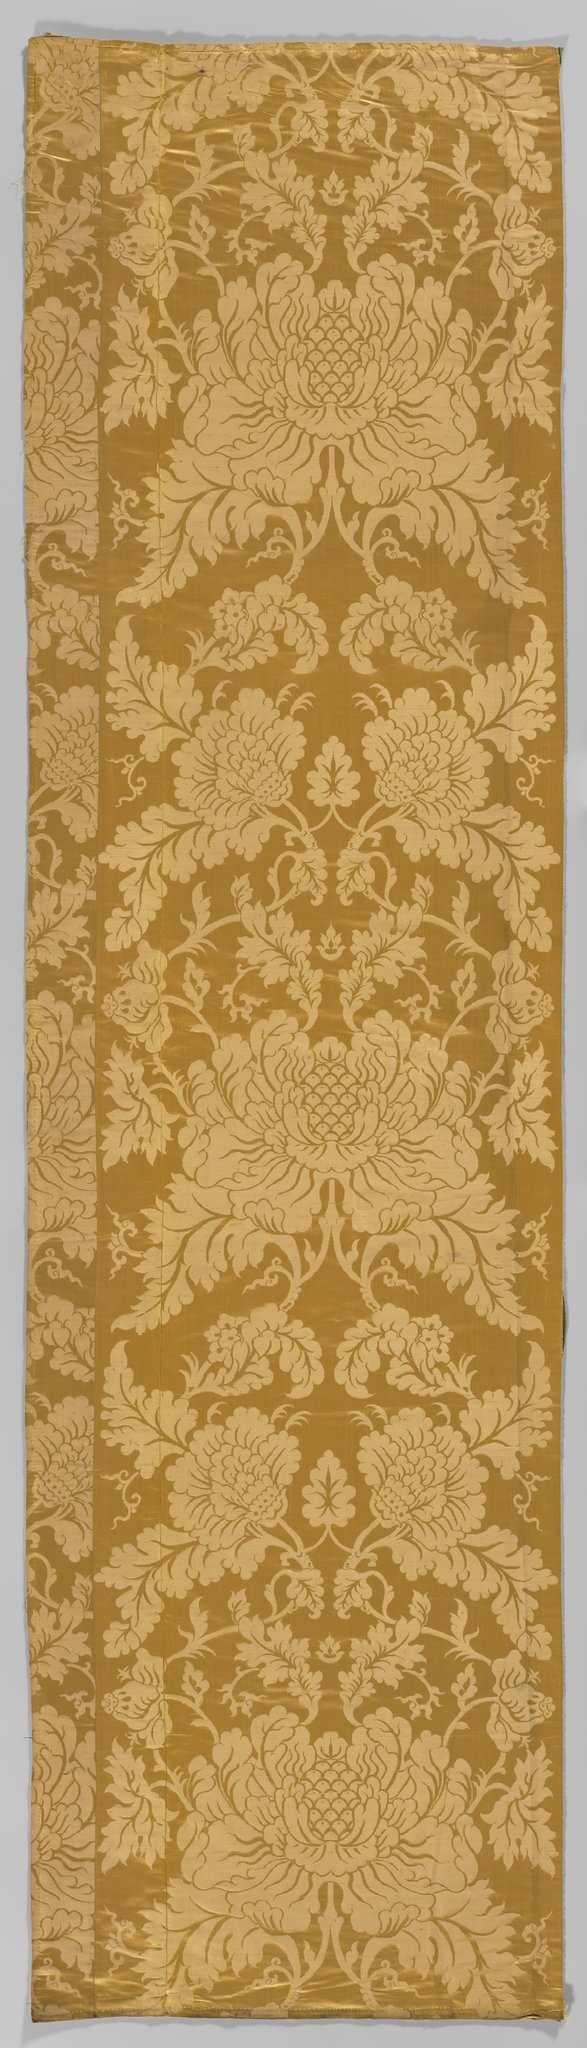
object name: silk textile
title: Baan van wandbespanning van geel zijden damasten met symmetrisch patroon van twee opgaande golvende ranken met onder andere pioenvormige bloemen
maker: Anonymous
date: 1700-1725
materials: silk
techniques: damask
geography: france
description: Geel zijden damasten wandbespanning. Symmetrisch patroon van twee opgaande golvende ranken waaraan grote pioenvormige bloemen met geschubtd hart; kleinere bloemen zijn paarsgewijs geplaatst, evenals bloemknoppen, gevederde bladeren en arabeskrankjes, die eindigen in wolkenbanden. Patroon van keperstreep, fond van satijnbinding. Afkomstig uit het pand Voorstraat 140 te Dordrecht. Eén baan heeft aan de onderkant wat waterschade. Eén deel heeft 2 aan elkaar genaaide banen, de andere 12.